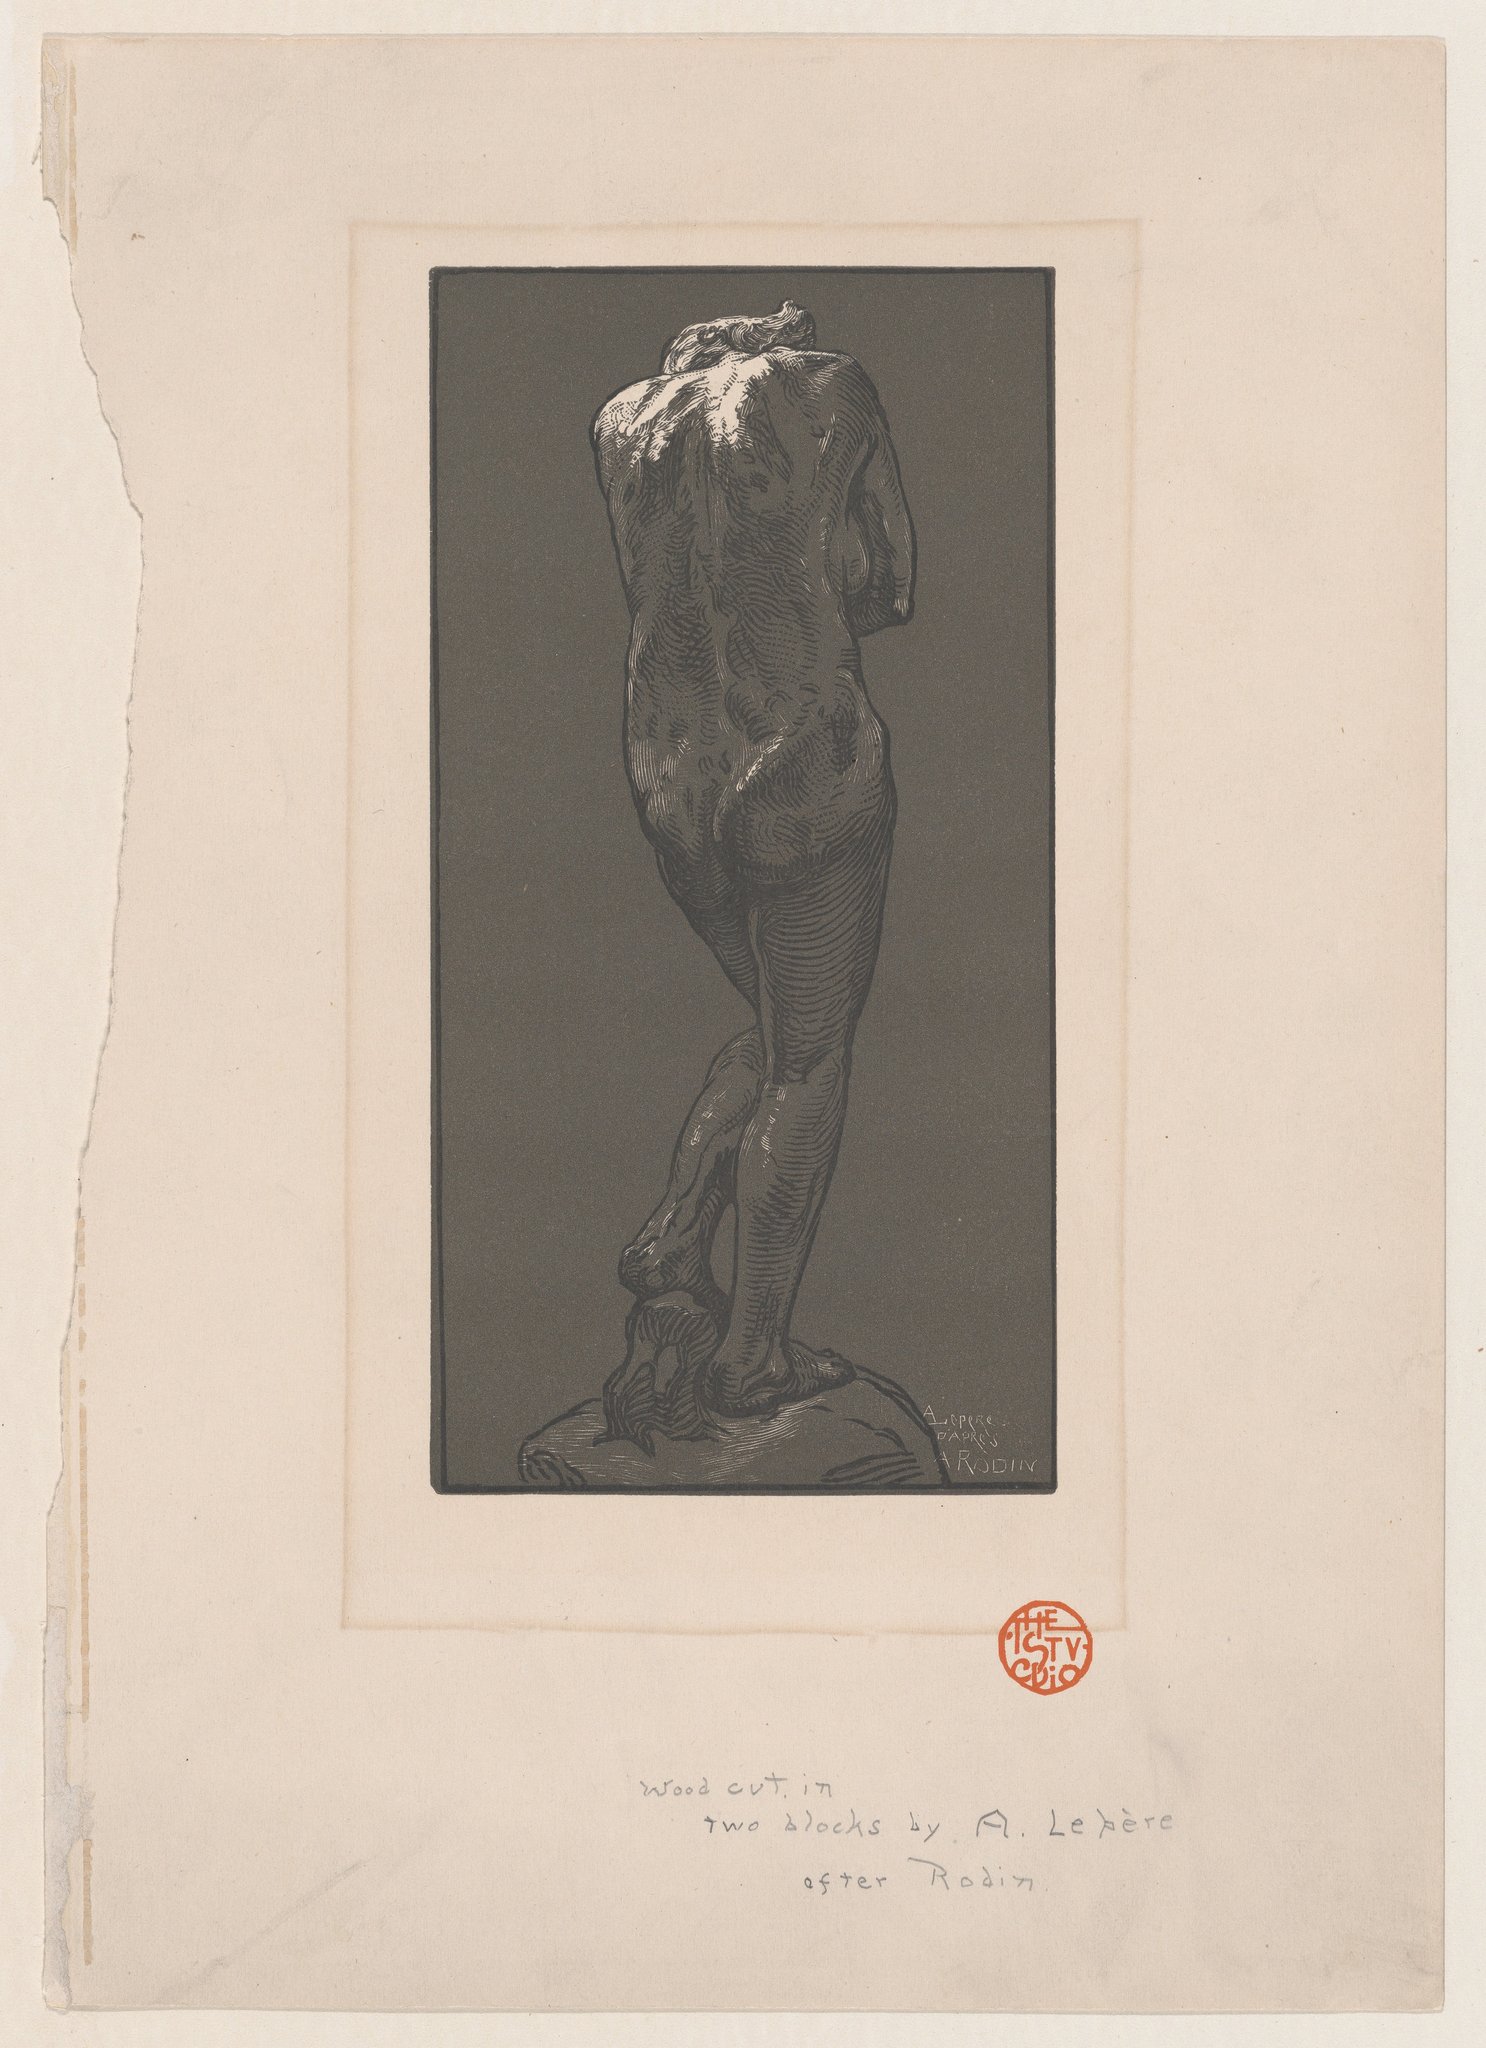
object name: print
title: Nude statue, seen from behind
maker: auguste-louis lepère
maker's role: artist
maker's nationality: french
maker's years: 1849-1918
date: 1902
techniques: printing, woodcut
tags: human figures